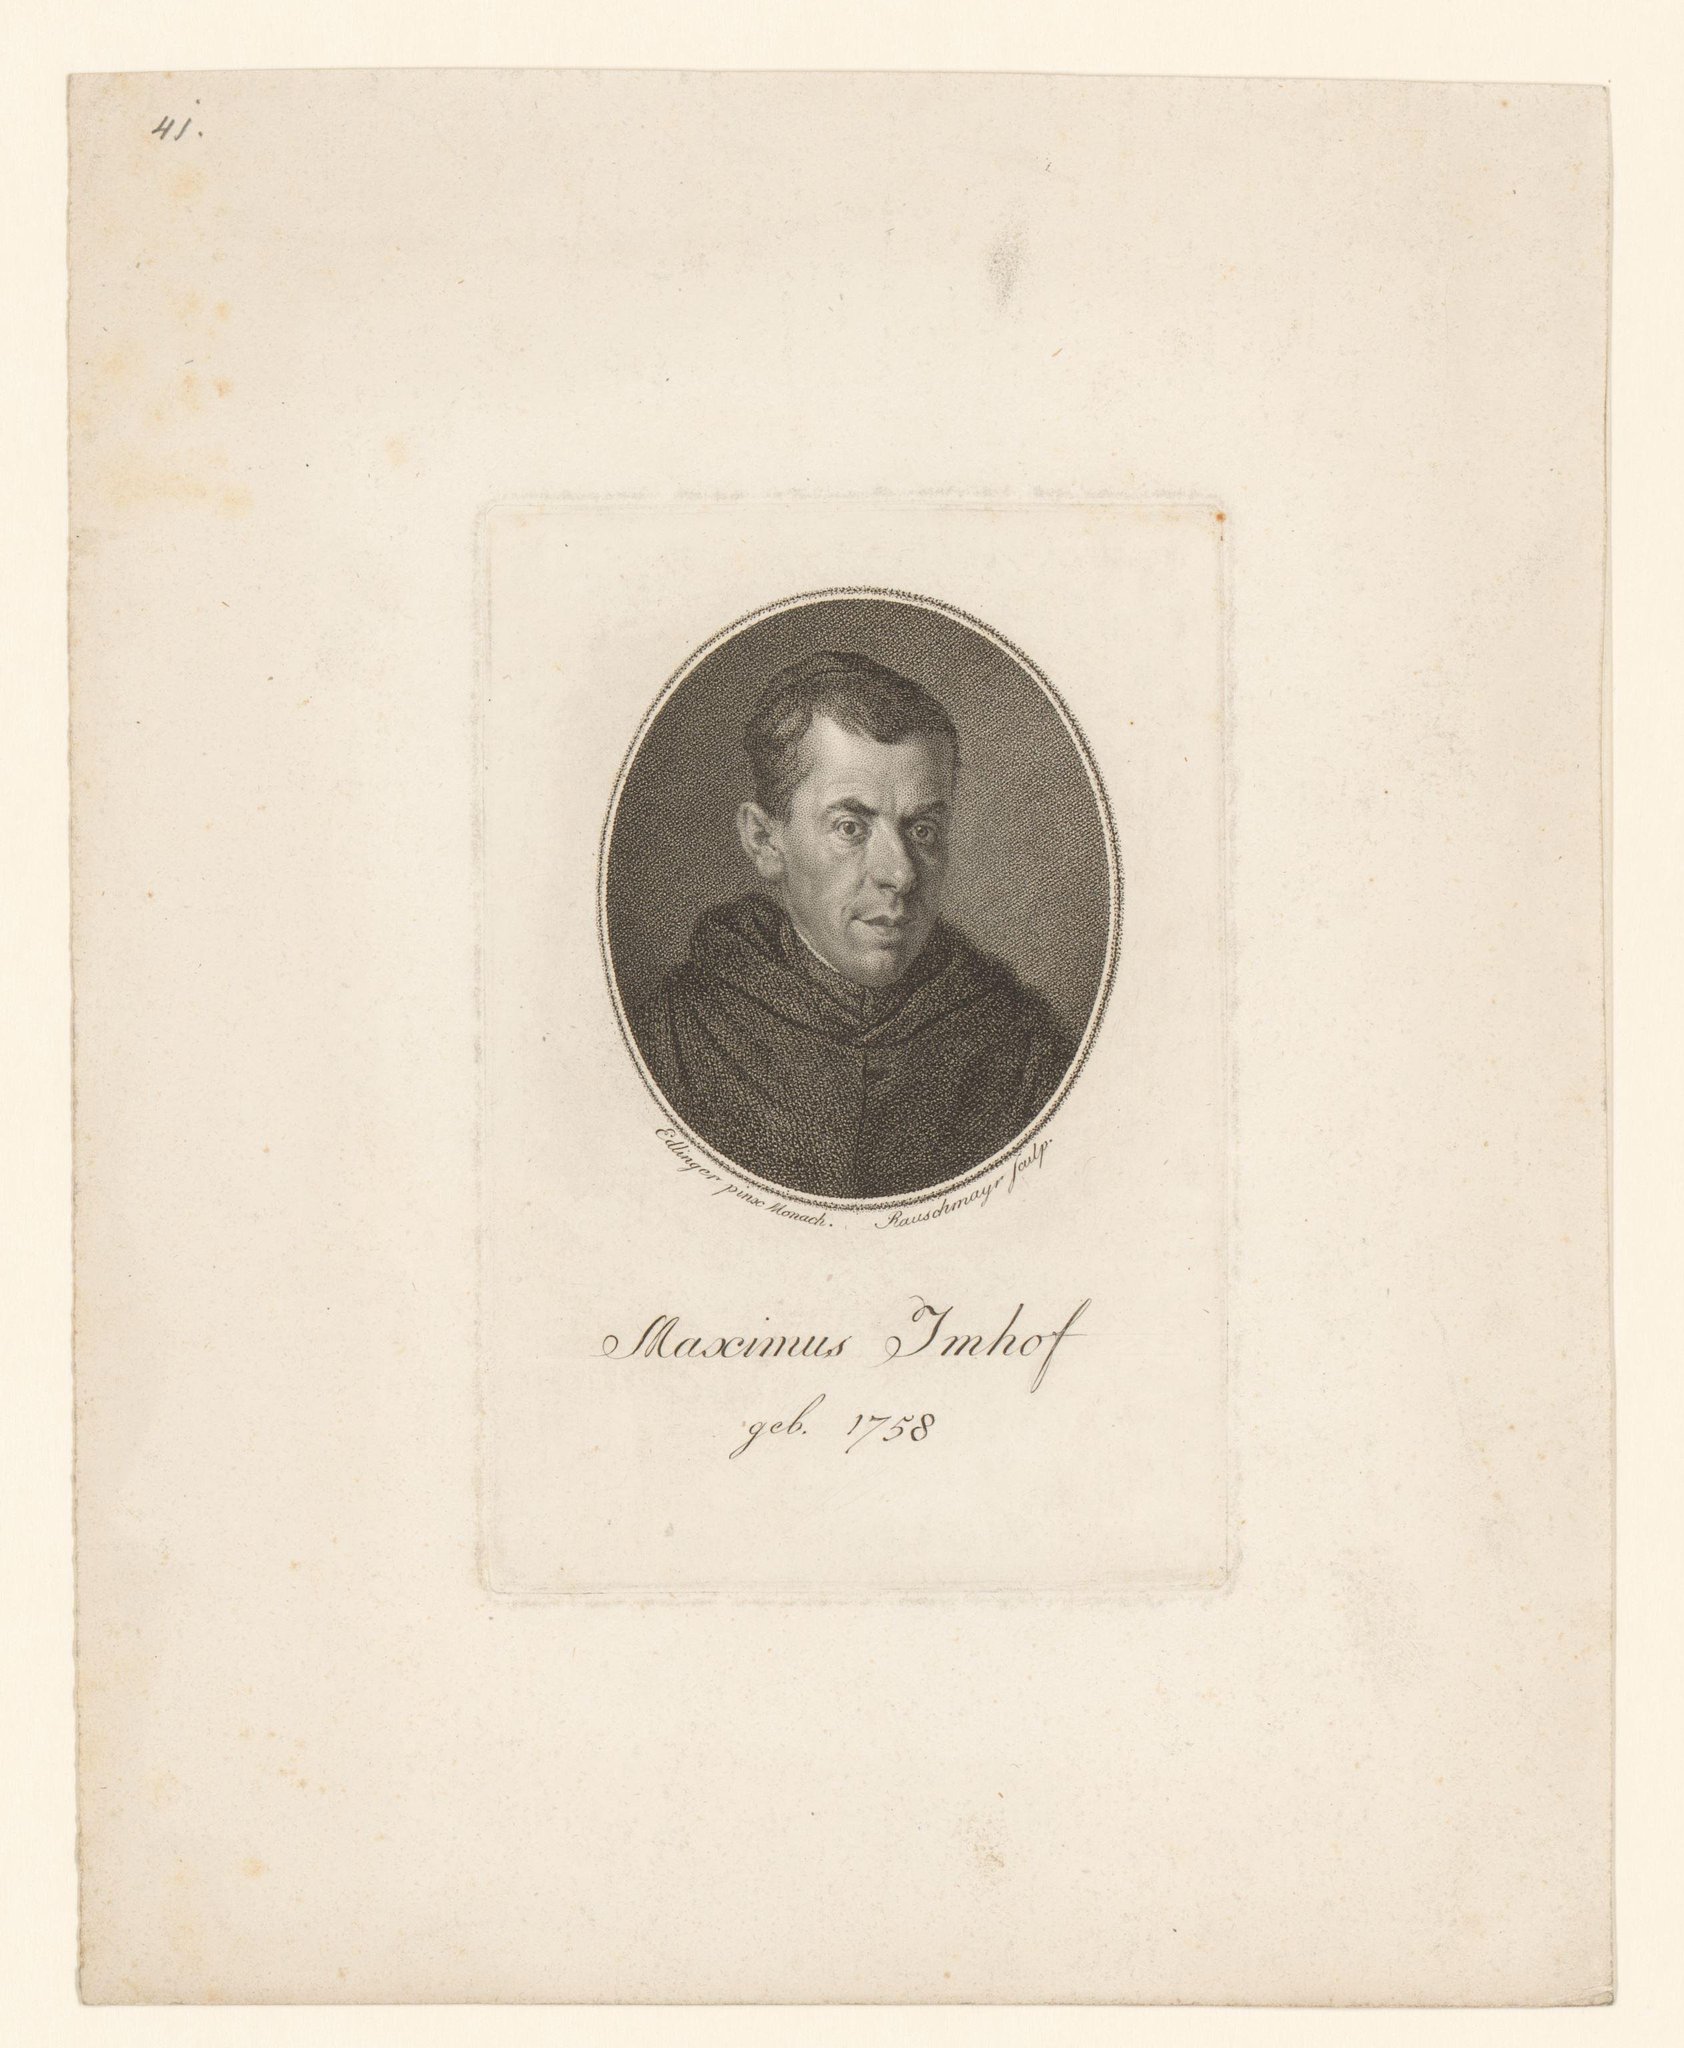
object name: print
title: Portret van Maximus von Imhof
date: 1768-1815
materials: paper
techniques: engraving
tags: physicist, historical persons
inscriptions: collector's mark: Lugt 2228